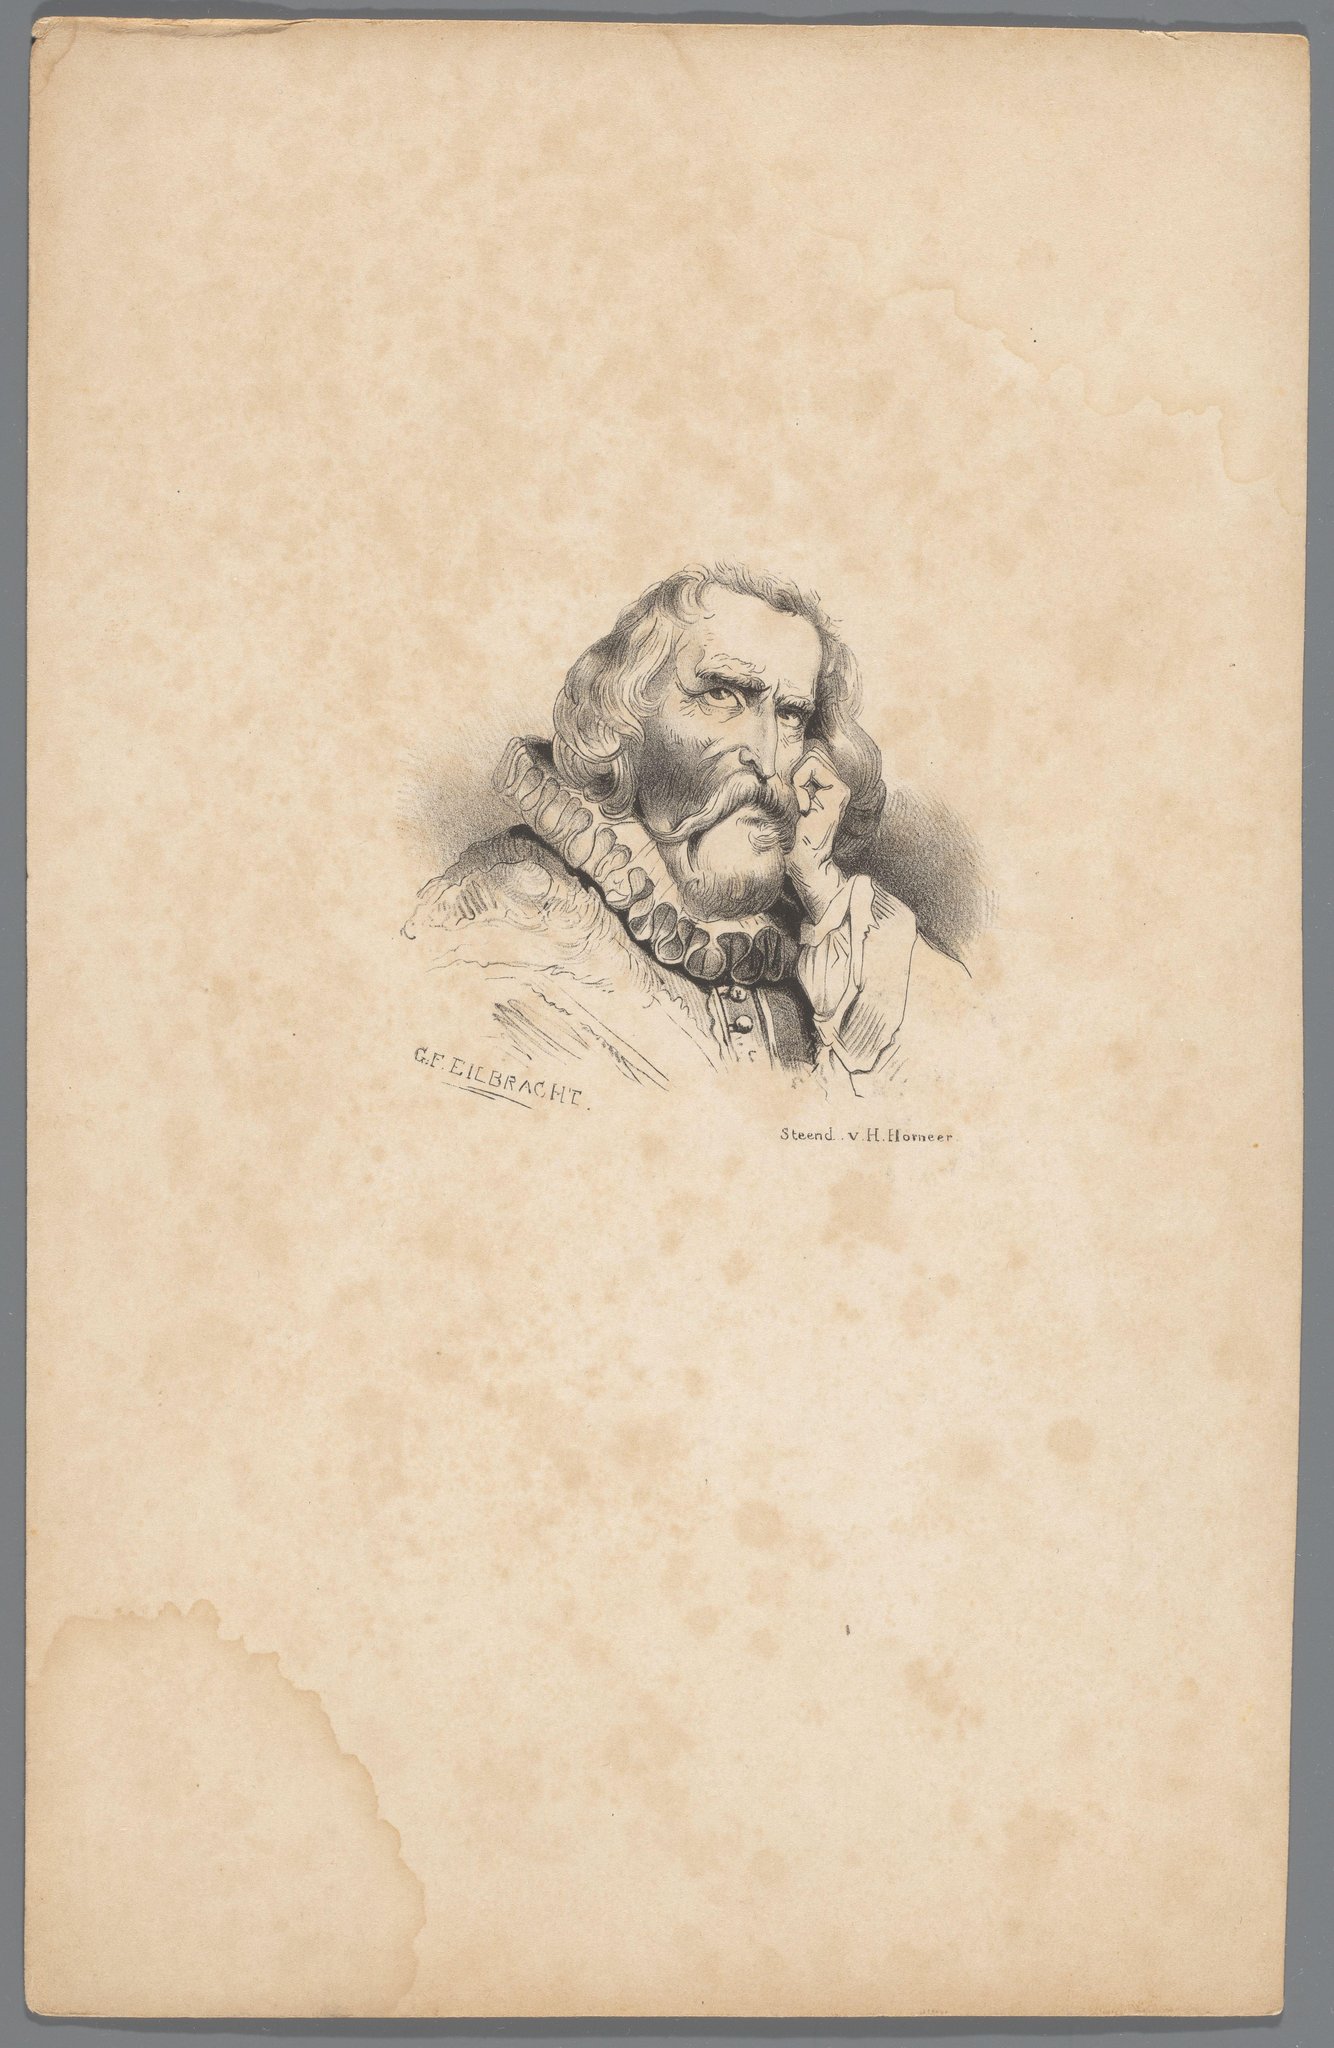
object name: wrapper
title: Man met hoofd geleund tegen hand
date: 1844-1854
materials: paper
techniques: lithograph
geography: netherlands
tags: (scenes from) specific works of literature (with author, title)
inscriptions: collector's mark: Lugt 2228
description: Buste van man met zijn hoofd geleund rustend in zijn hand. Los blad in een mapje met twaalf lithografieën naar de houtgravures gebruikt als illustraties in: Félix Bogaerts, El Maestro del Campo, 1839.